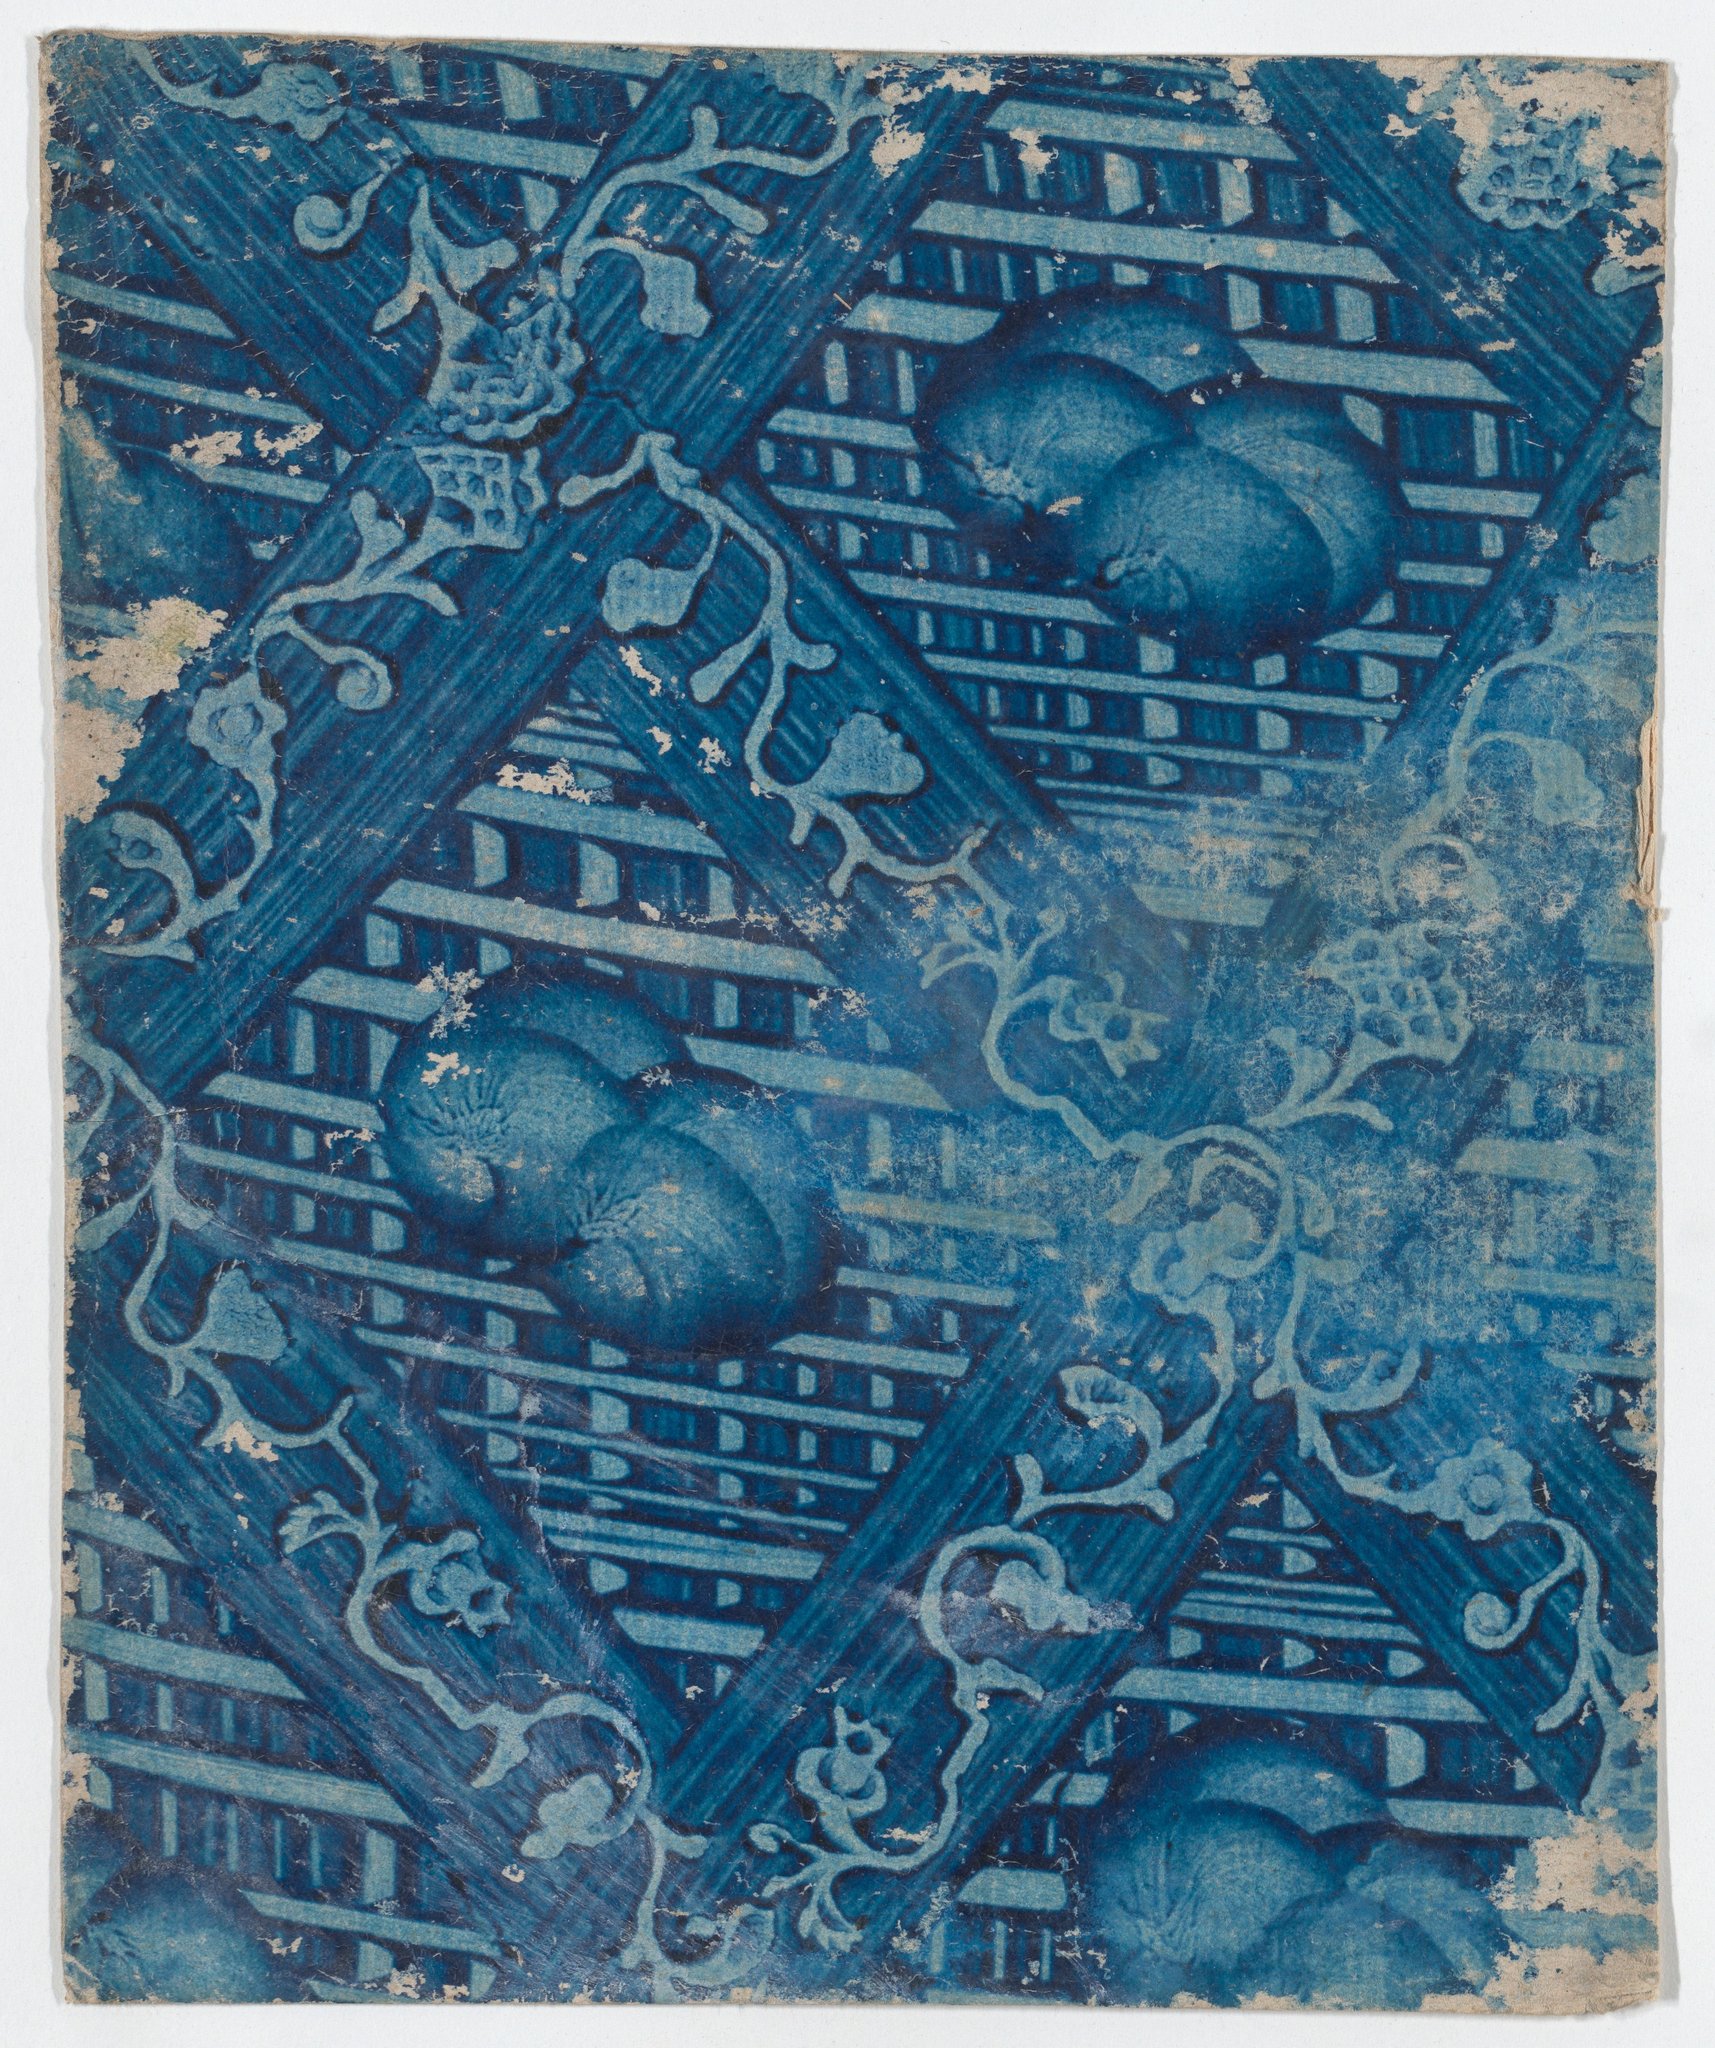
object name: print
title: Blue paste paper with striped and floral pattern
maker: Anonymous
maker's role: artist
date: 1760-1770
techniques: relief print